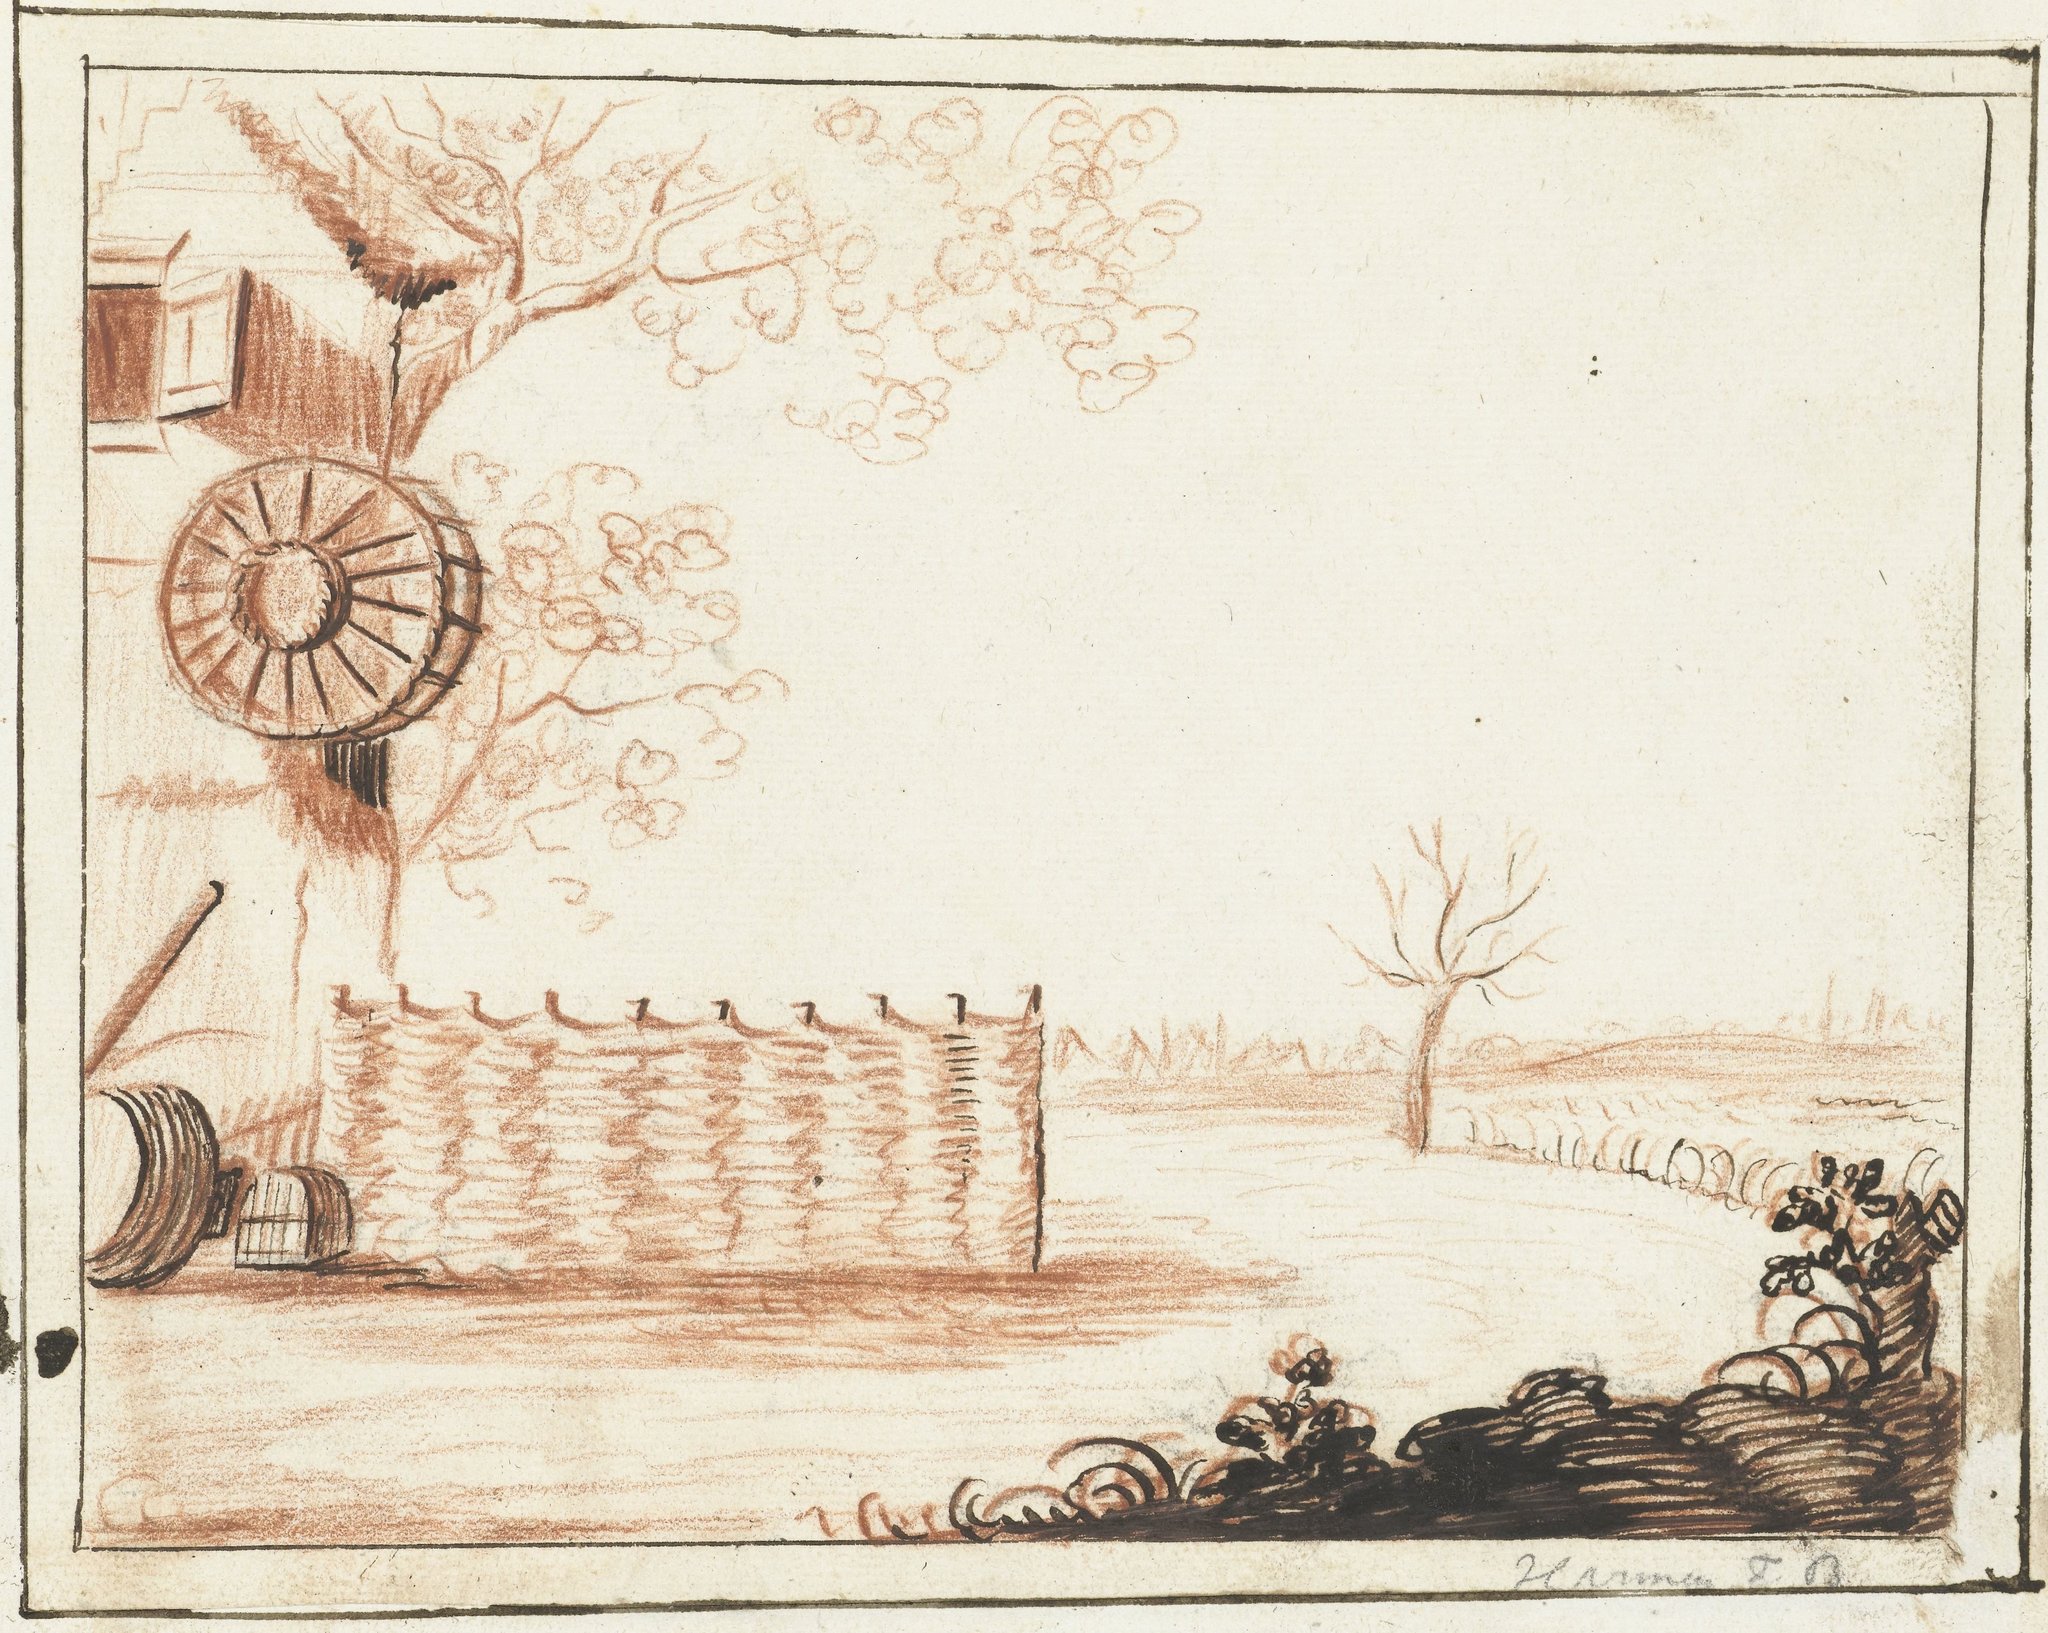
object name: drawing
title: Boerenerf met werktuigen en hek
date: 1643-1687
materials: chalk, paper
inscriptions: annotation: ‘Harmen T.B’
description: Tekening naast twee andere tekeningen in het Familie-plakboek geplakt.